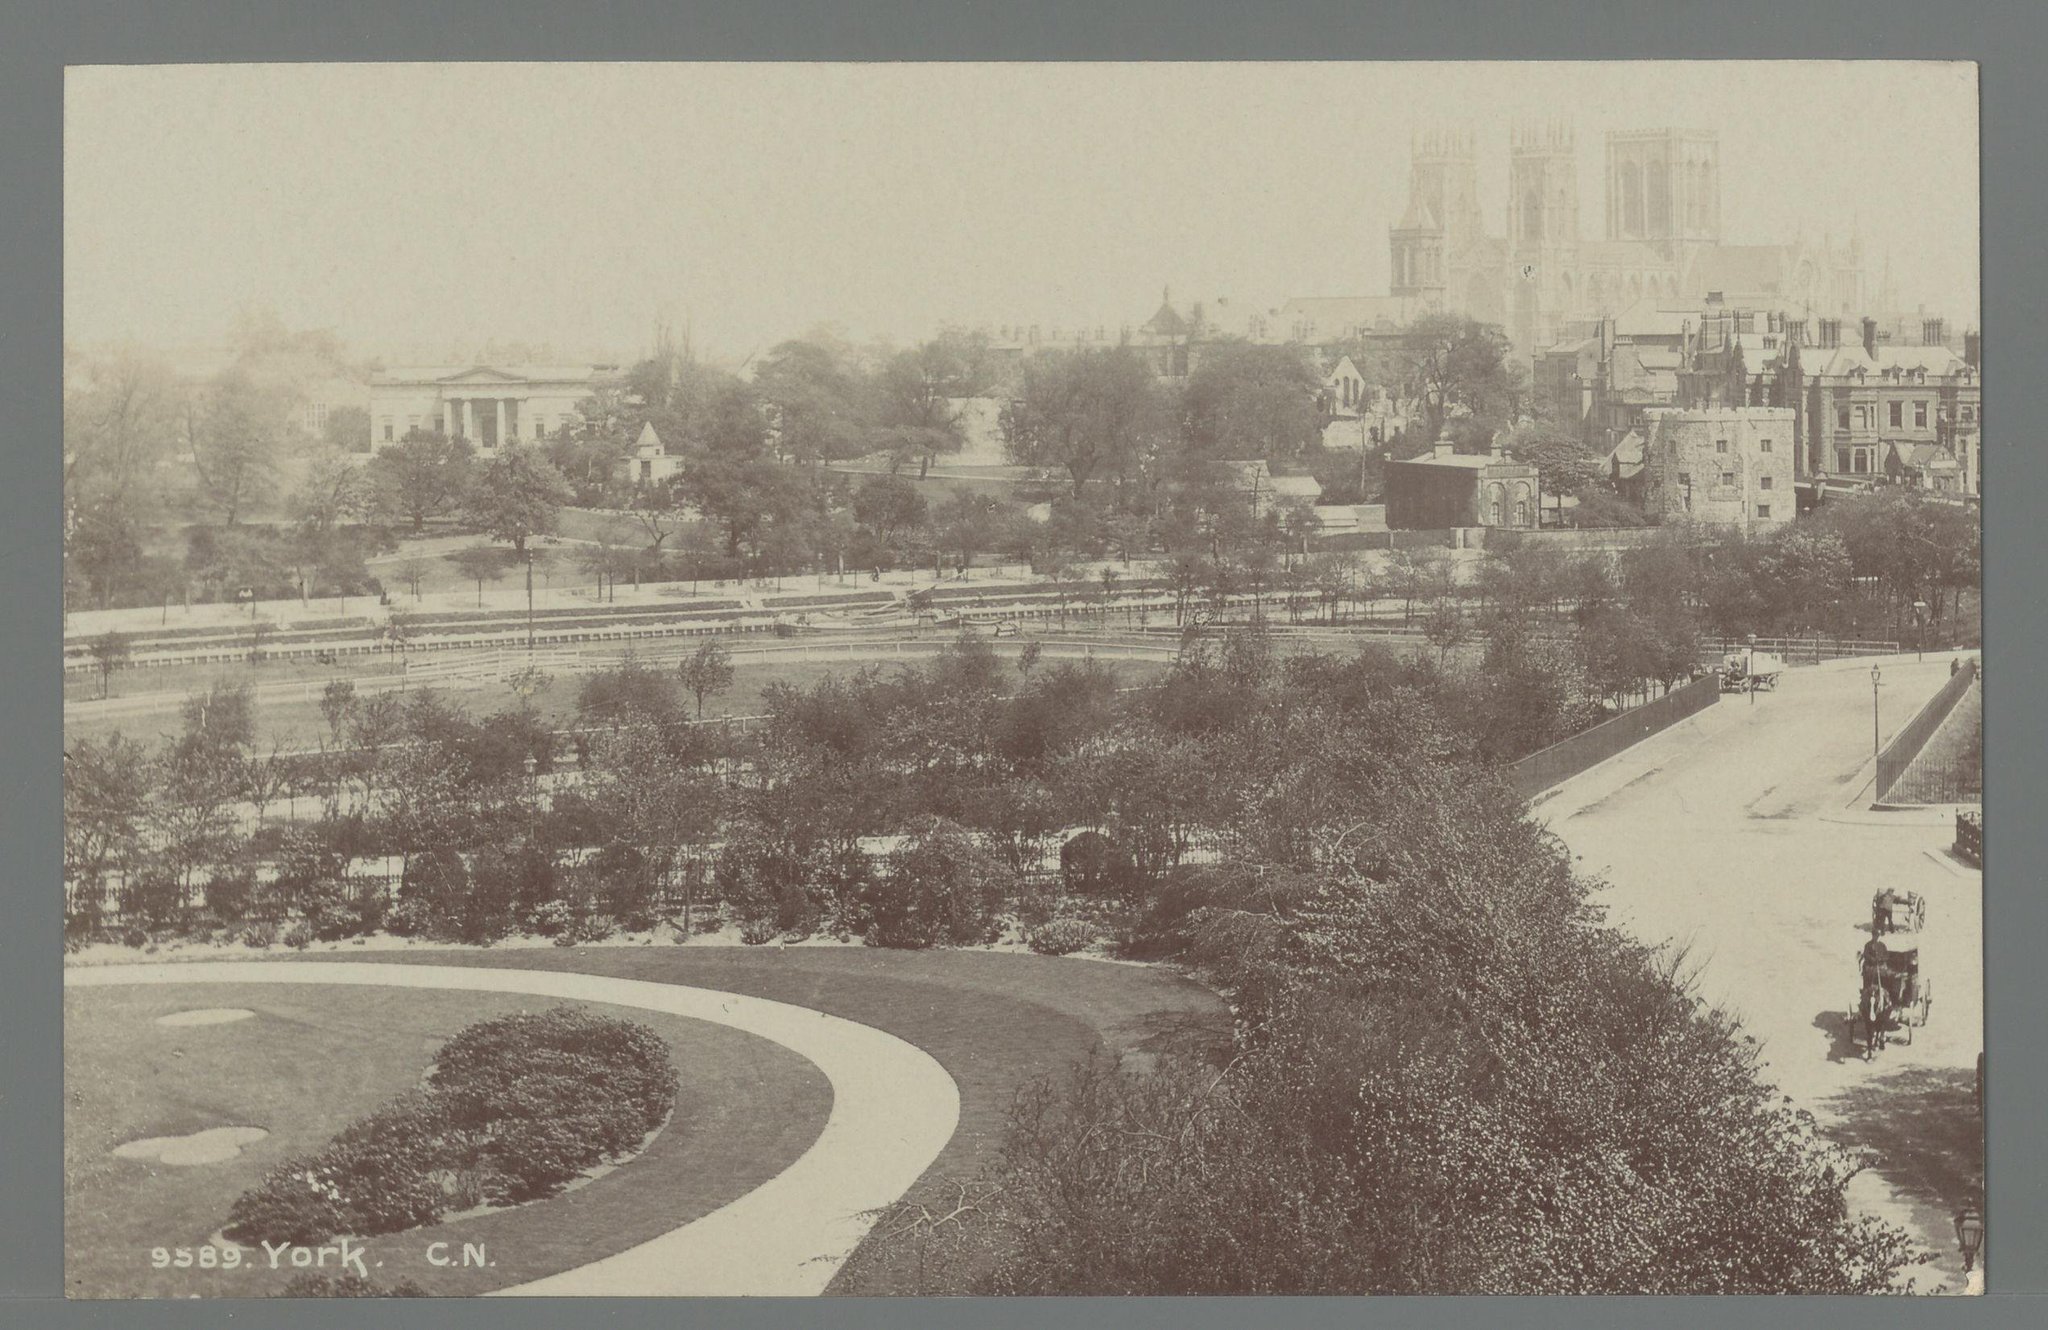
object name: photograph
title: York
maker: Anonymous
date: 1902-1918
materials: paper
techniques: gelatin silver print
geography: london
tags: church (exterior), prospect of city, town panorama, silhouette of city